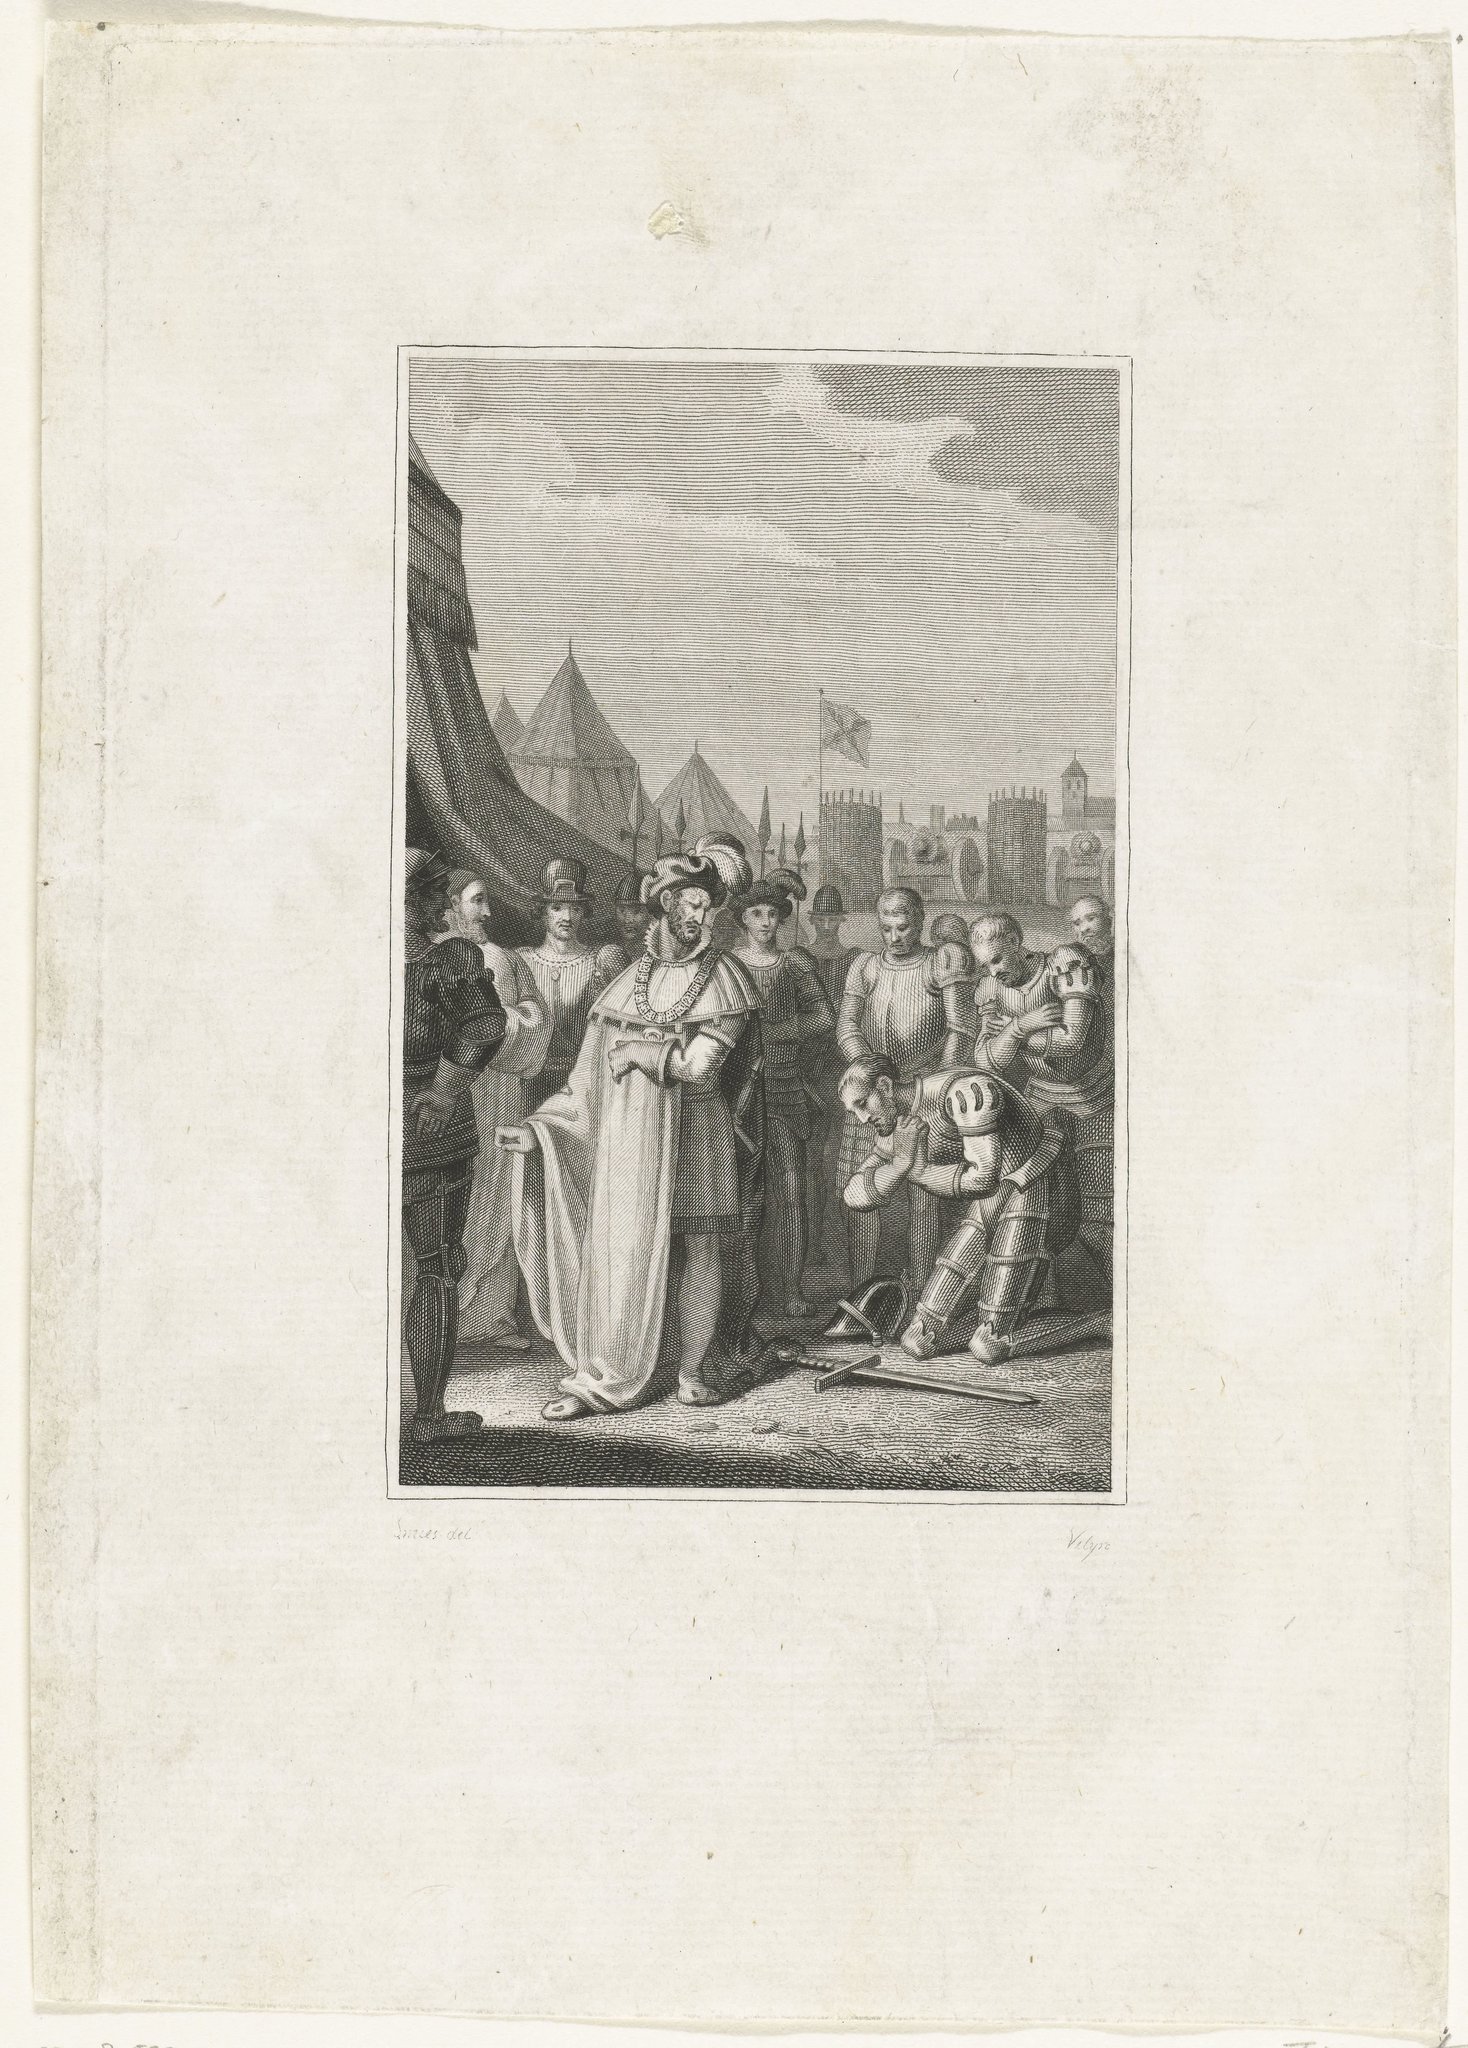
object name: history print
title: Willem II van Gelre onderwerpt zich aan keizer Karel V, 1543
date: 1823-1829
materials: paper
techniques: etching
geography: netherlands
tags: ghent, charles v (holy roman emperor and king of spain), defeat ~ armed conflict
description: Illustratie voor: P.G. Witsen Geysbeek en G. Engelberts Gerrits, Schoonheden en merkwaardige tafereelen uit de Nederlandsche geschiedenis. G. Portielje, Amsterdam 1825-1829, 8 delen. Staat vóór de letter.